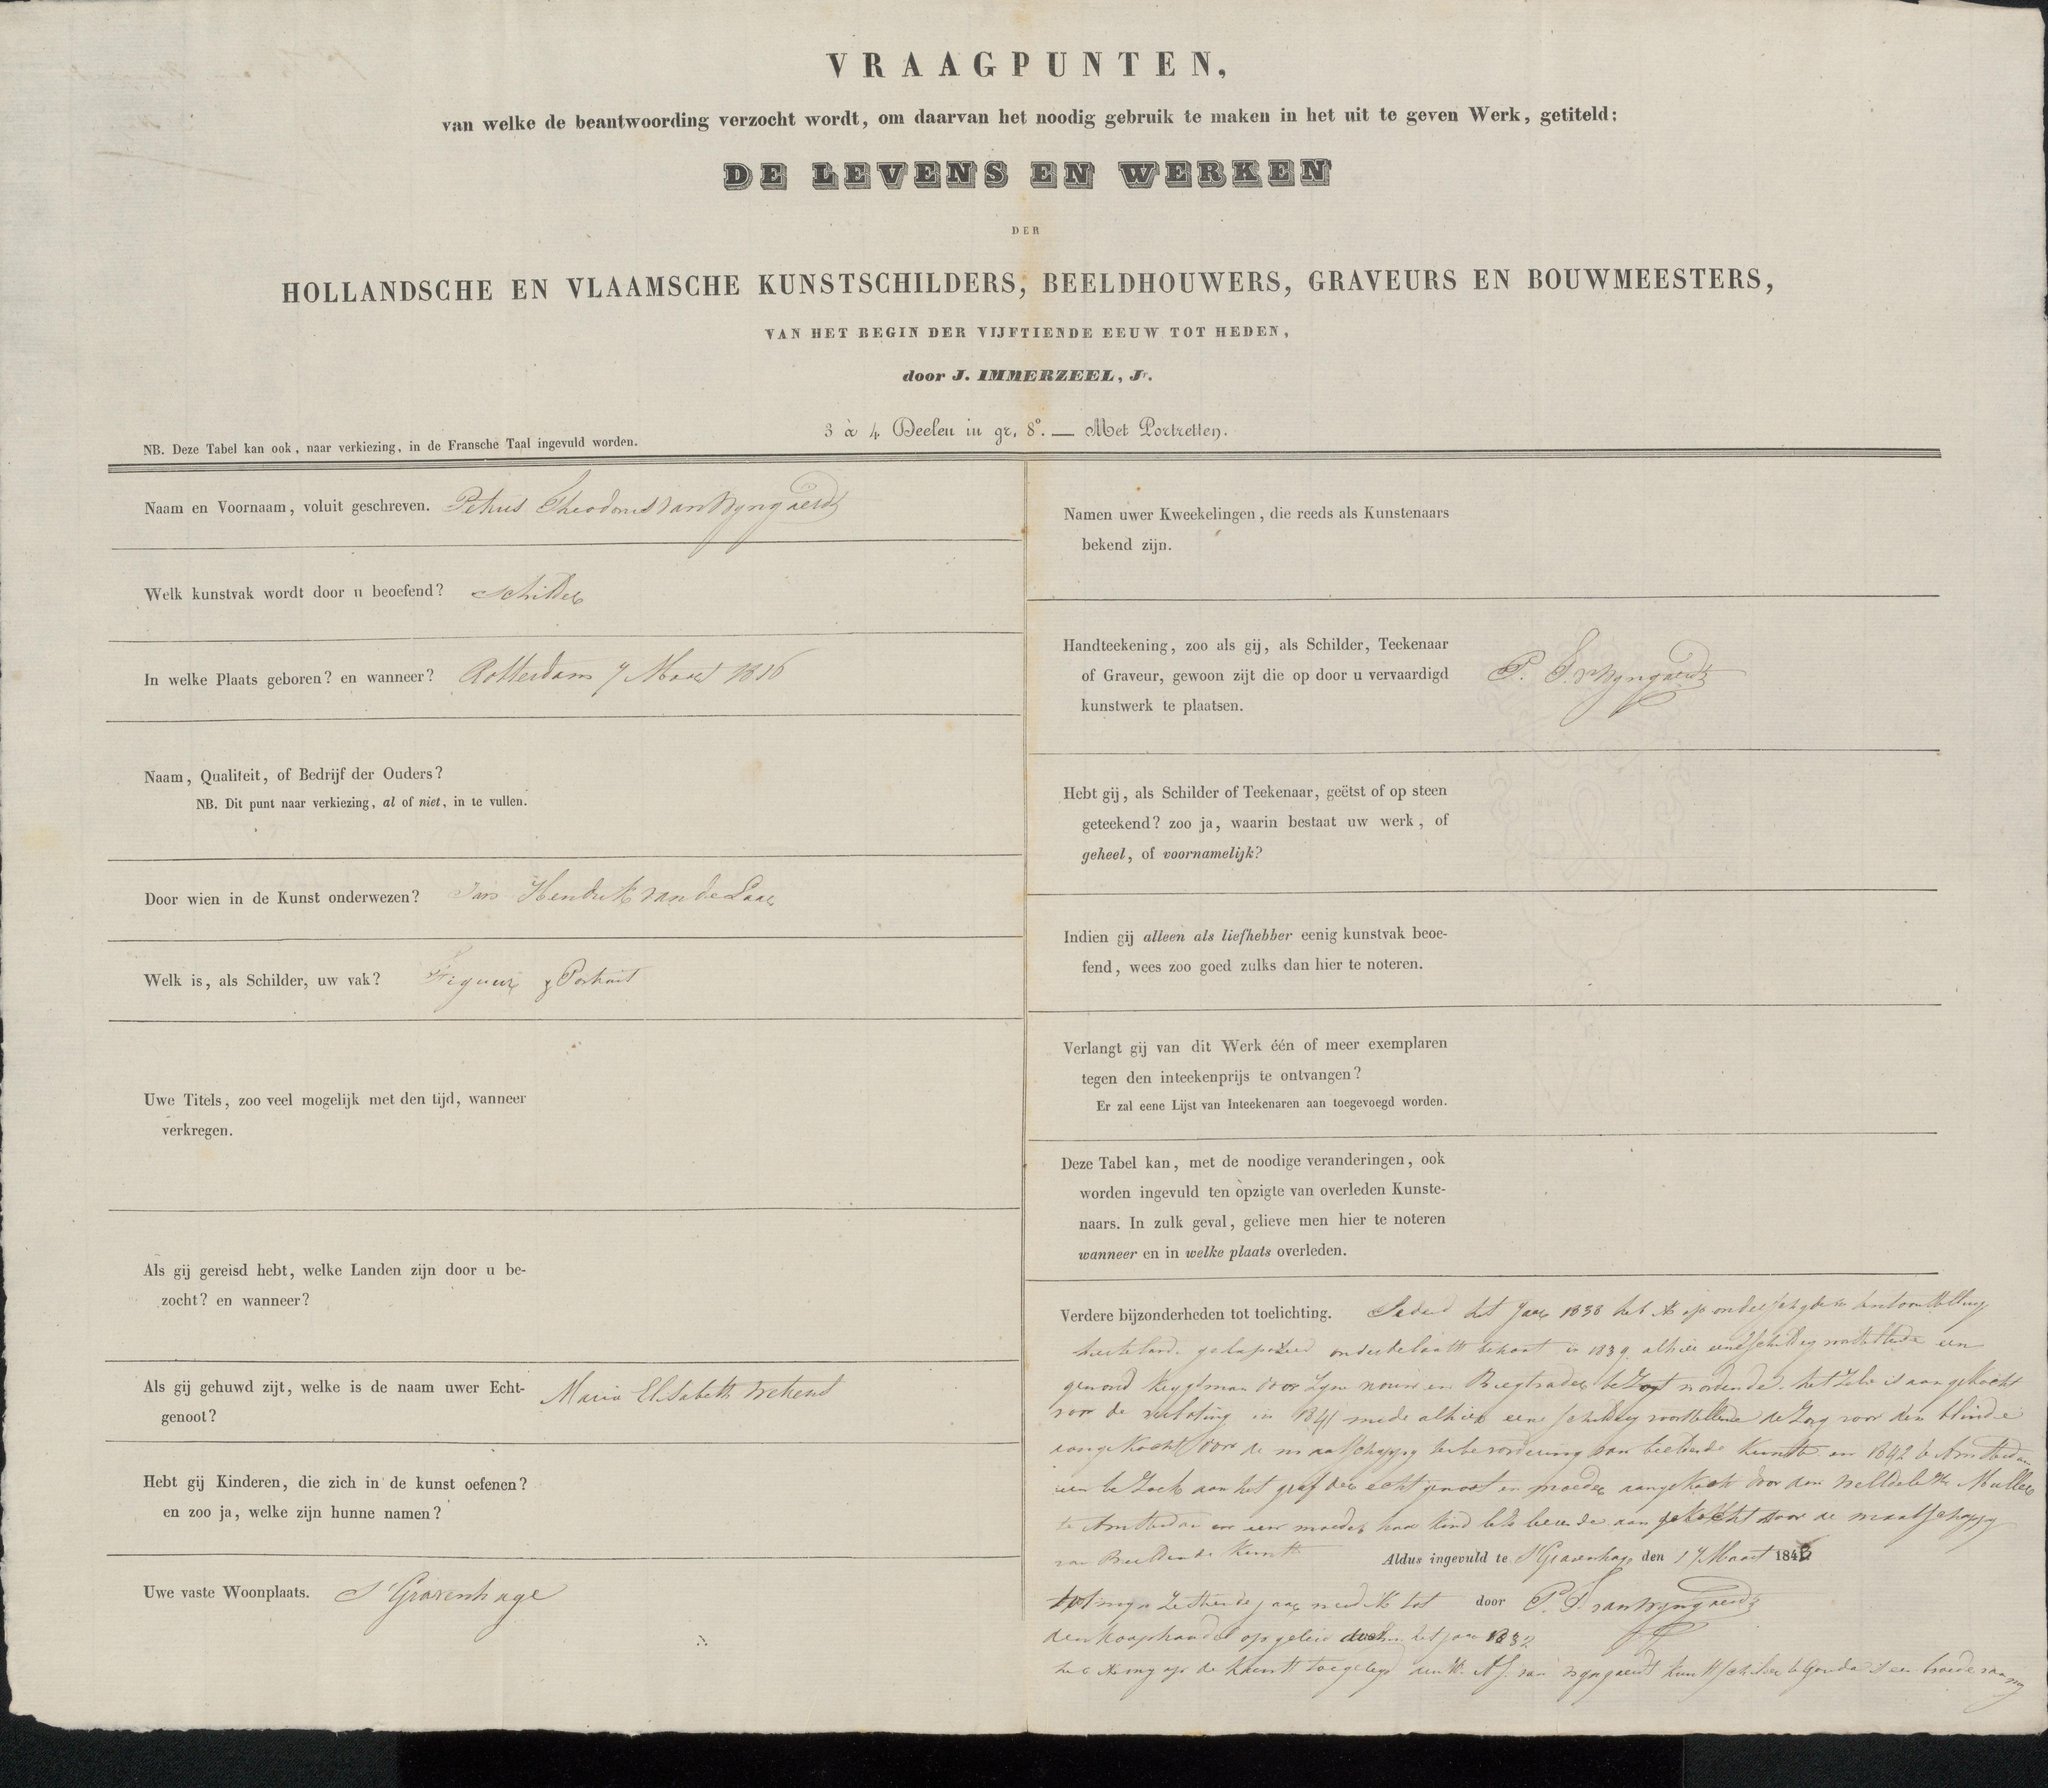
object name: questionnaire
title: Enquêteformulier ingevuld door Petrus Theodorus van Wijngaerdt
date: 1843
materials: ink, paper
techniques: pen, printing, writing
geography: the hague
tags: rotterdam, haarlem, print maker, draughtsman, petrus theodorus van wijngaerdt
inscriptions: watermark, inscription: ‘Vraagpunten,/ van welke de beantwoording verzocht wordt, om daarvan het noodig gebruik te maken in het uit te geven Werk, getiteld: De levens en werken/ der Hollandsche en Vlaamsche kunstschilders, beeldhouwers,/ graveurs en bouwmeesters, van het begin der vijftiende eeuw tot heden/ door J. Immerzeel, Jr.’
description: Opgenomen in: Immerzeel, J. Jr., De levens en werken der Hollandsche en Vlaamsche kunstschilders, beeldhouwers, graveurs en bouwmeesters, van het begin der vijftiende eeuw tot heden, Amsterdam: J.C. van Kesteren, 1842-1843.